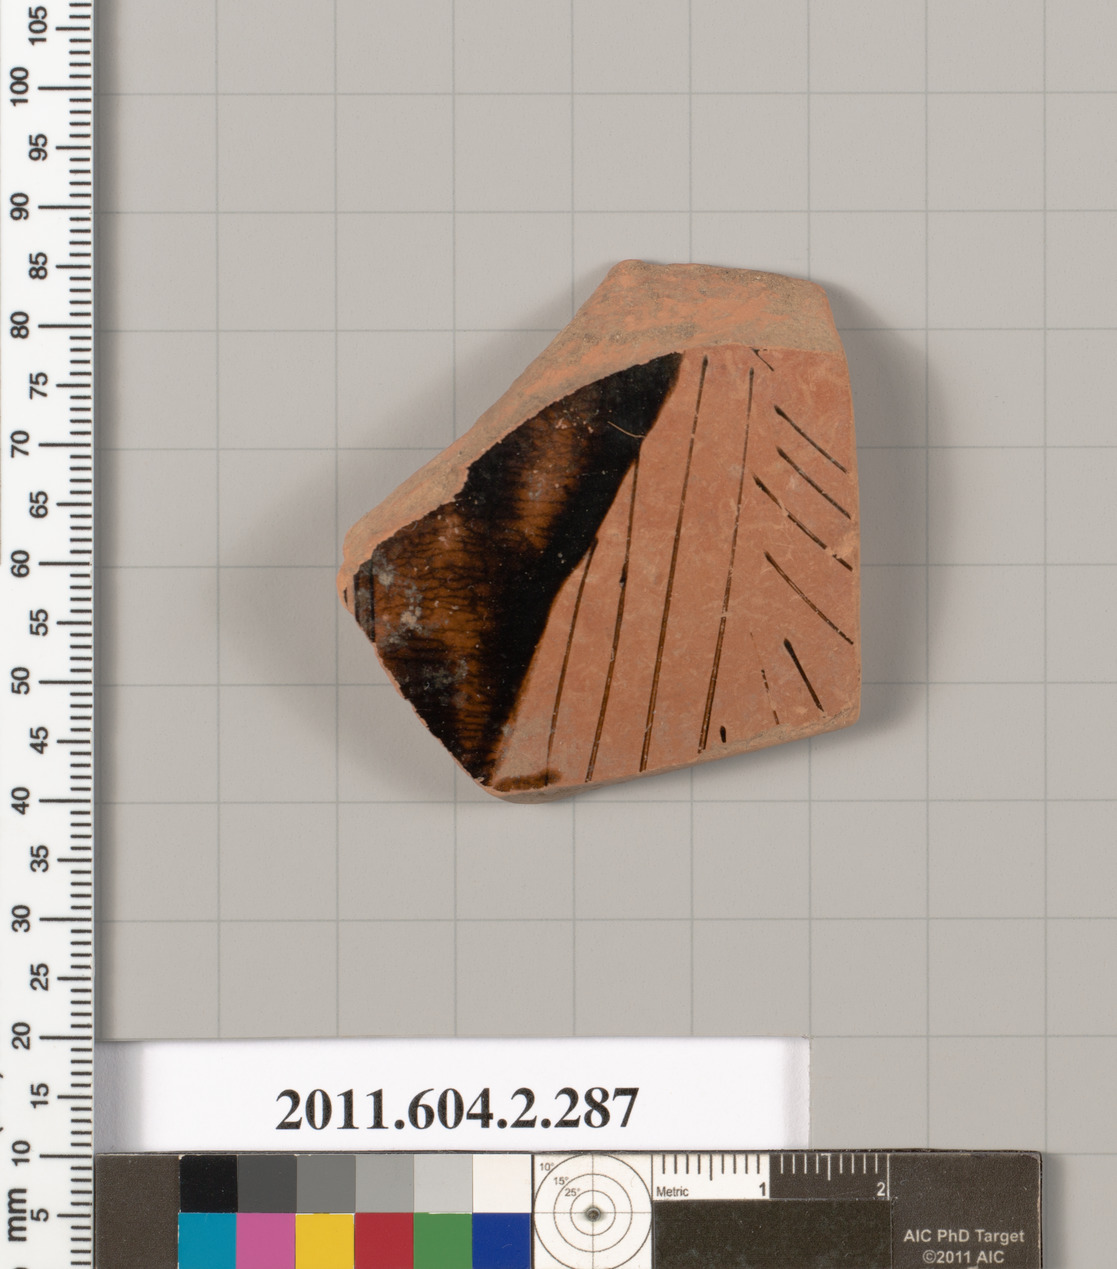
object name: column krater fragment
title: Terracotta fragment of a column-krater? (bowl for mixing wine and water)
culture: greek, attic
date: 450-426 BCE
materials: terracotta